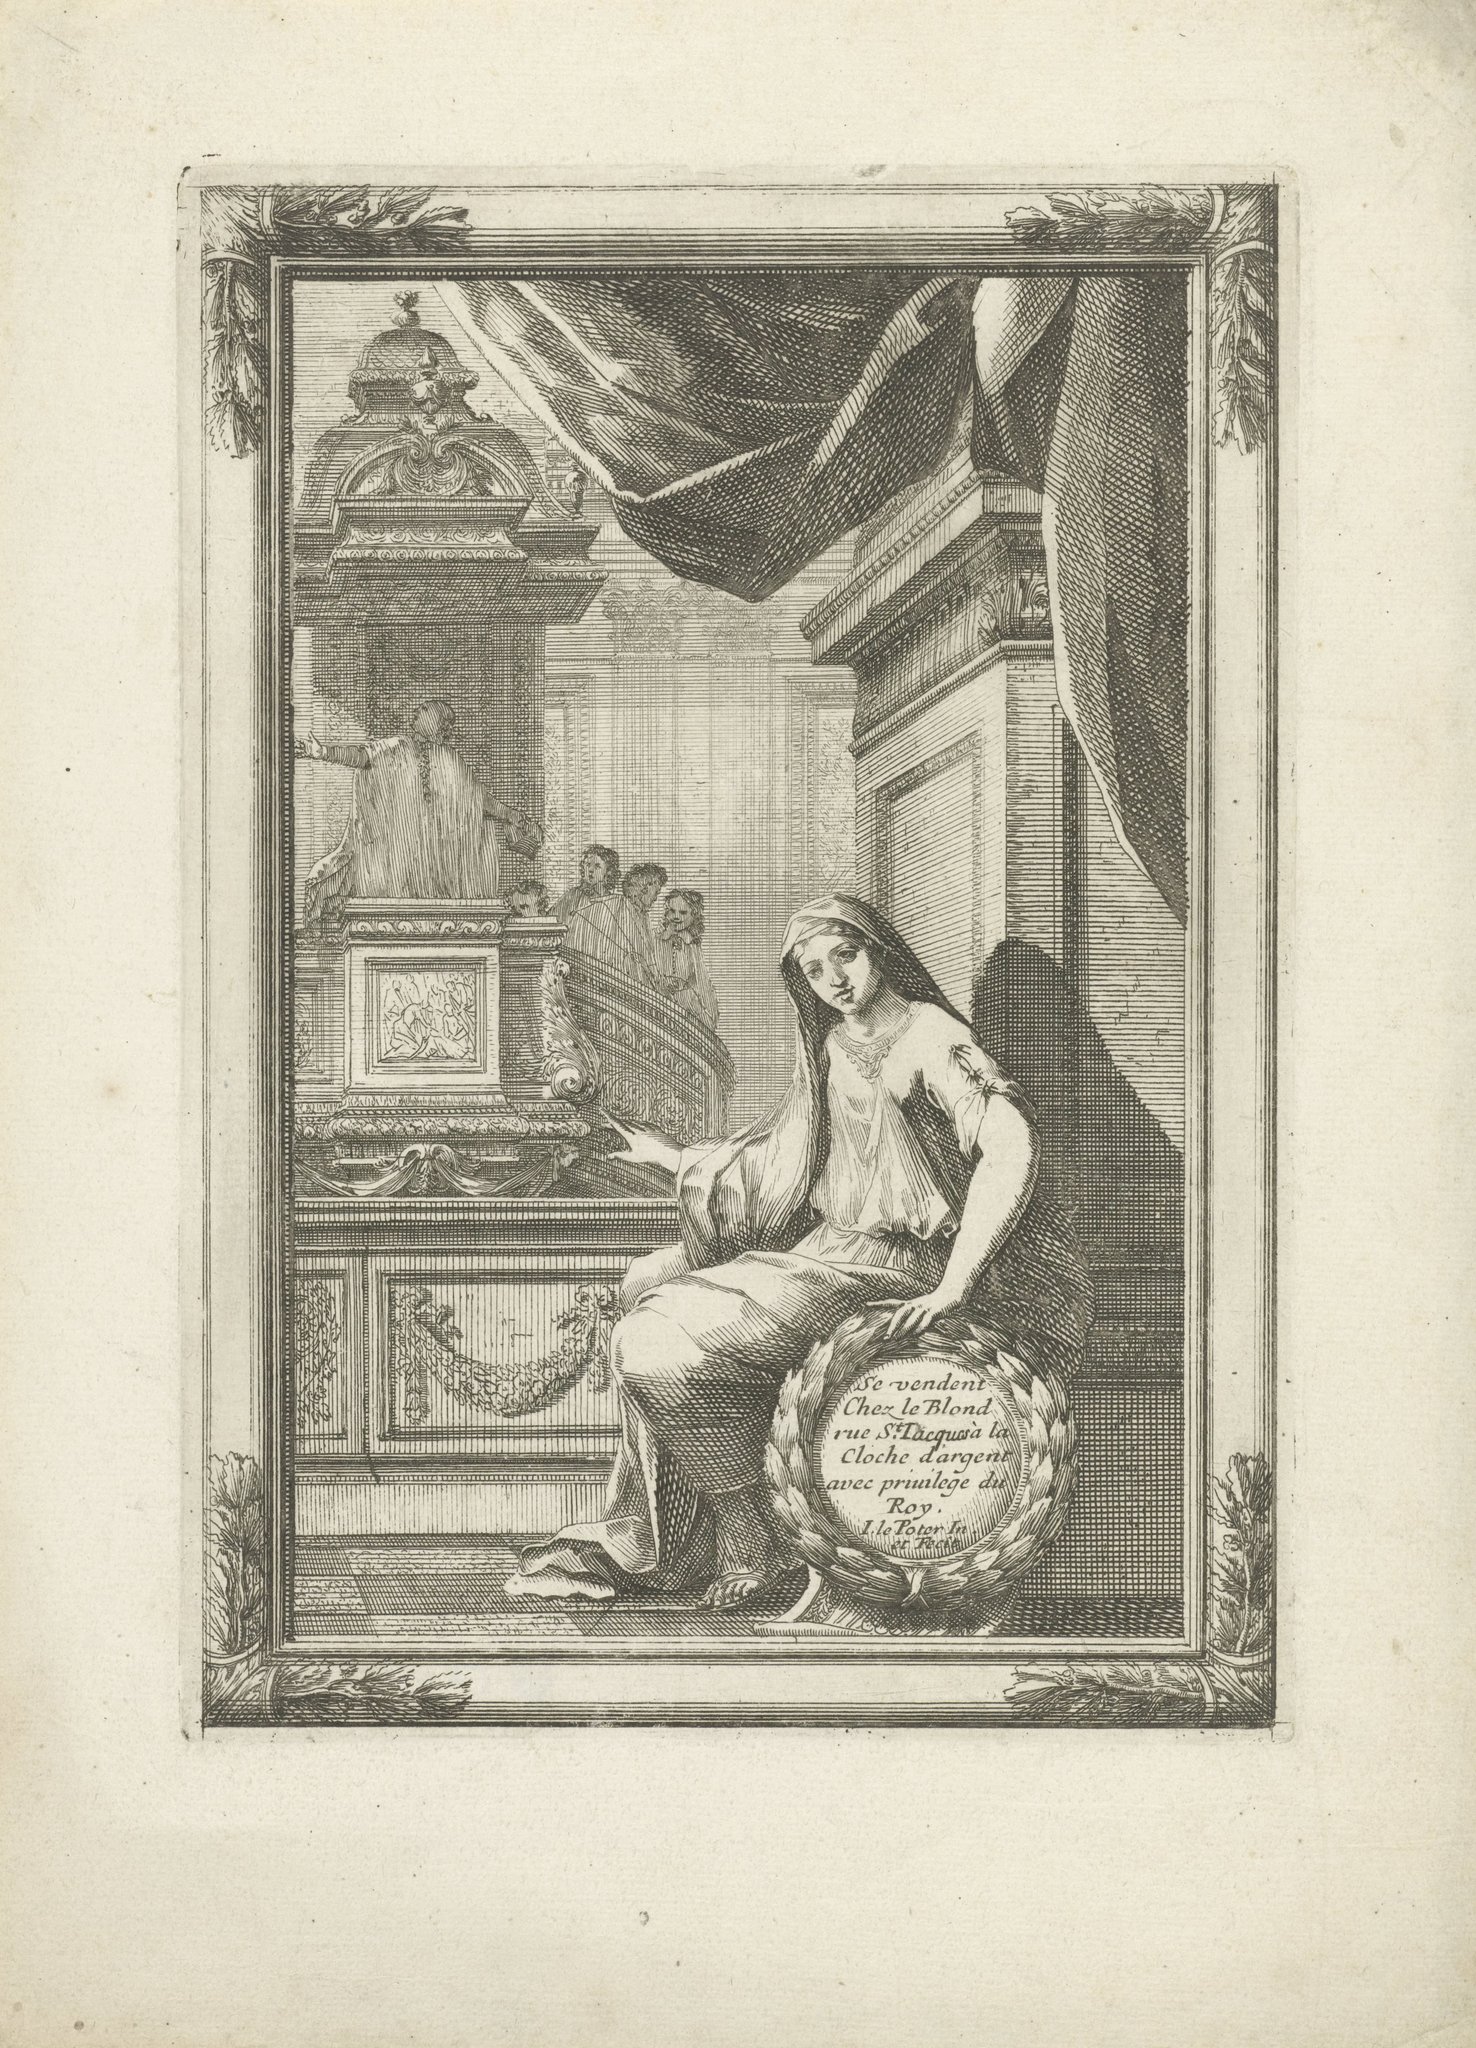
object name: ornament print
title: Zittende vrouw met medaillon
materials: paper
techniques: etching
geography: paris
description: De vrouw wijst met haar rechterhand naar de kansel op de achtergrond. In het medaillon staat het adres van de uitgever. Uit tweede editie van serie van 6 bladen.